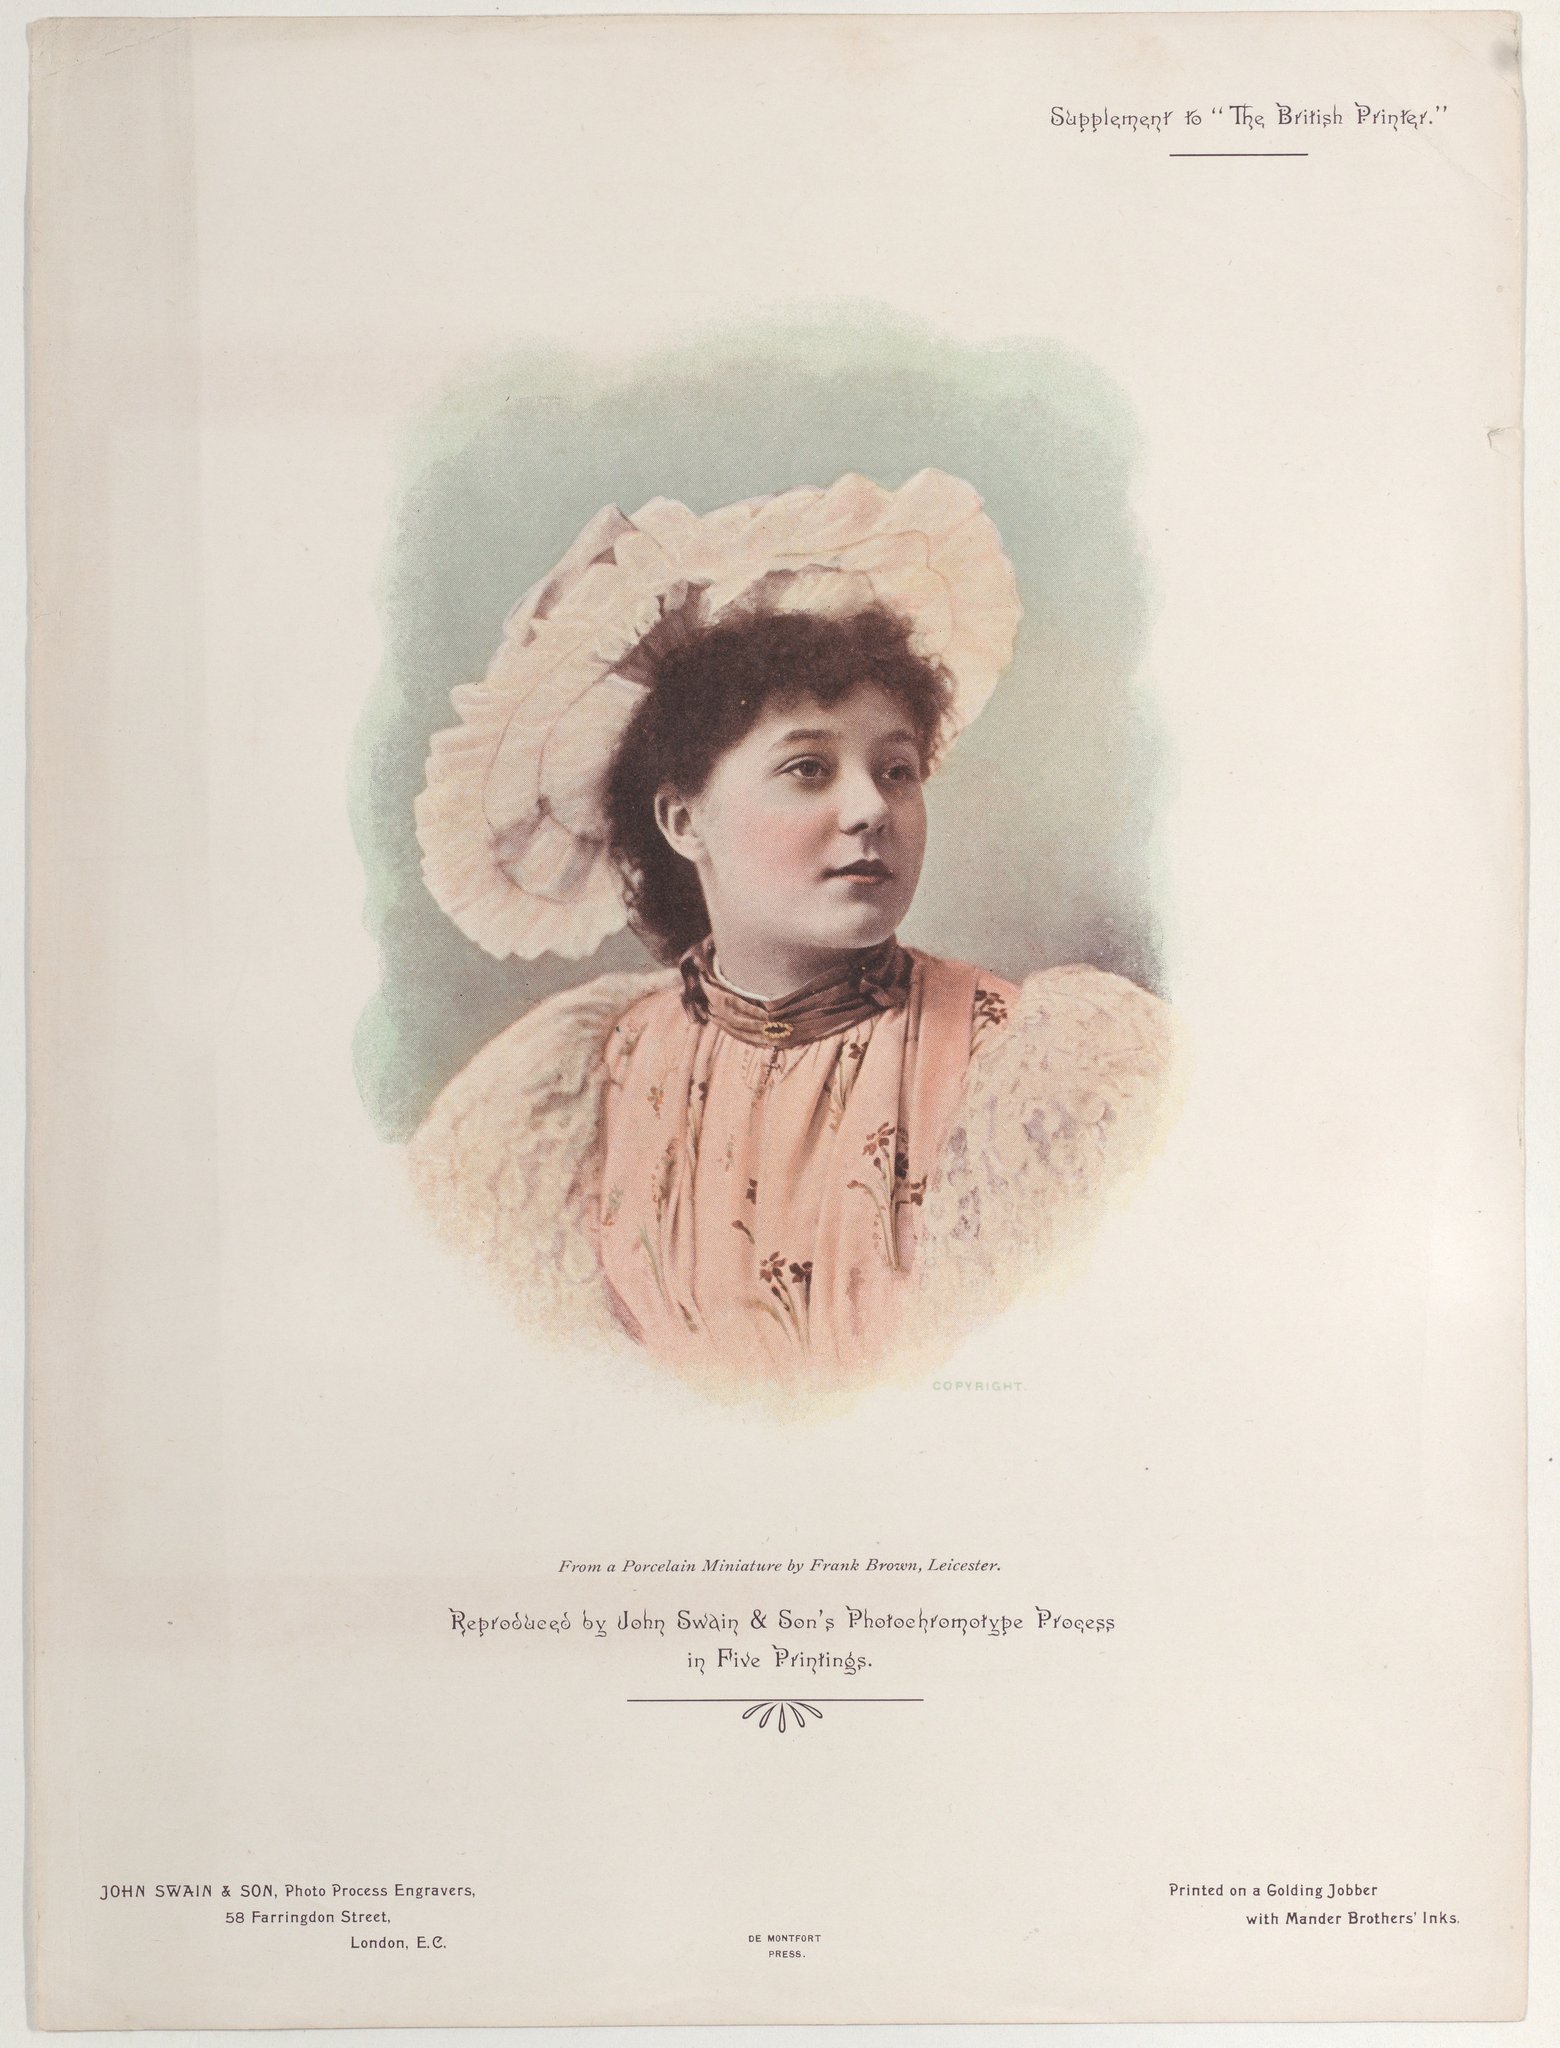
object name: print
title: Advertisement for John Swain & Son, Photo Process Engravers in "The British Printer"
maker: anonymous, british, 19th century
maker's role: artist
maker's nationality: british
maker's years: 1800-1900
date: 1801-1900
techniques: lithography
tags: women,advertisements